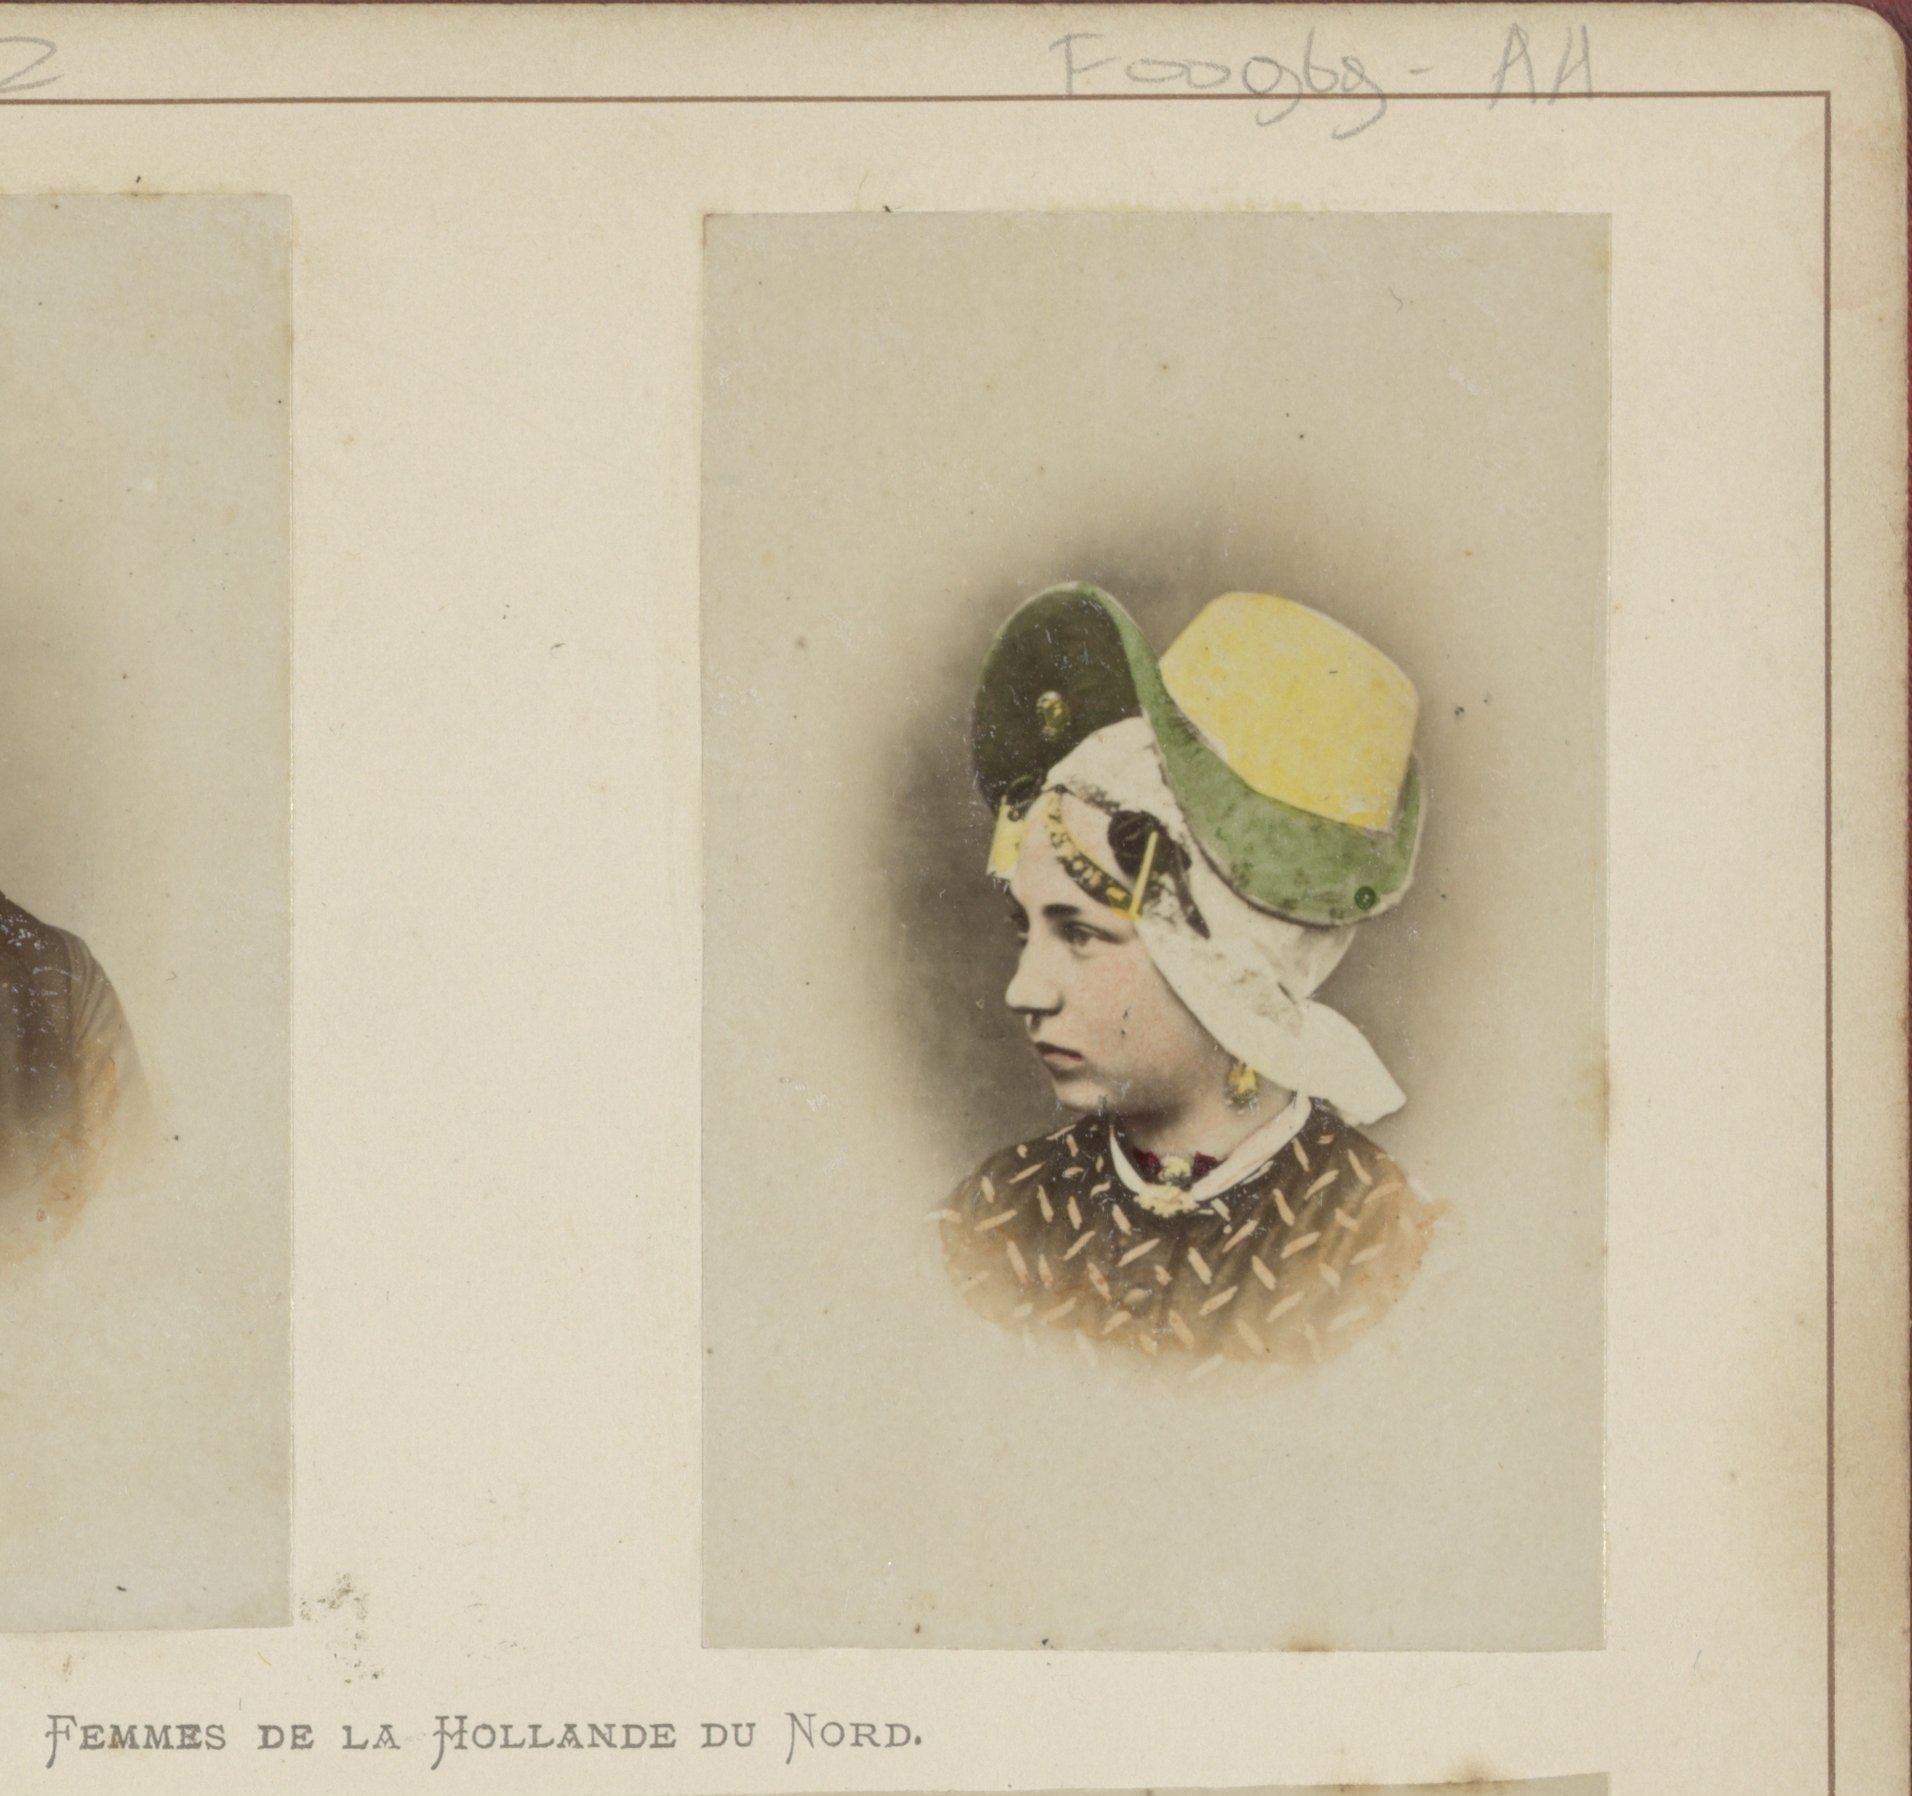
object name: photograph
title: Portret van een vrouw in de klederdracht van Noord-Holland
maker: andries jager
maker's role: publisher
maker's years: 1825-1905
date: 1878-1890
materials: cardboard, paper, photographic support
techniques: albumen print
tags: historical persons, clothing for the upper part of the body, head-gear: cap, folk costume, regional costume, necklace, anonymous historical person portrayed - bb - woman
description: Onderdeel van Leporelloalbum met 28 foto's van Amsterdam en omstreken.